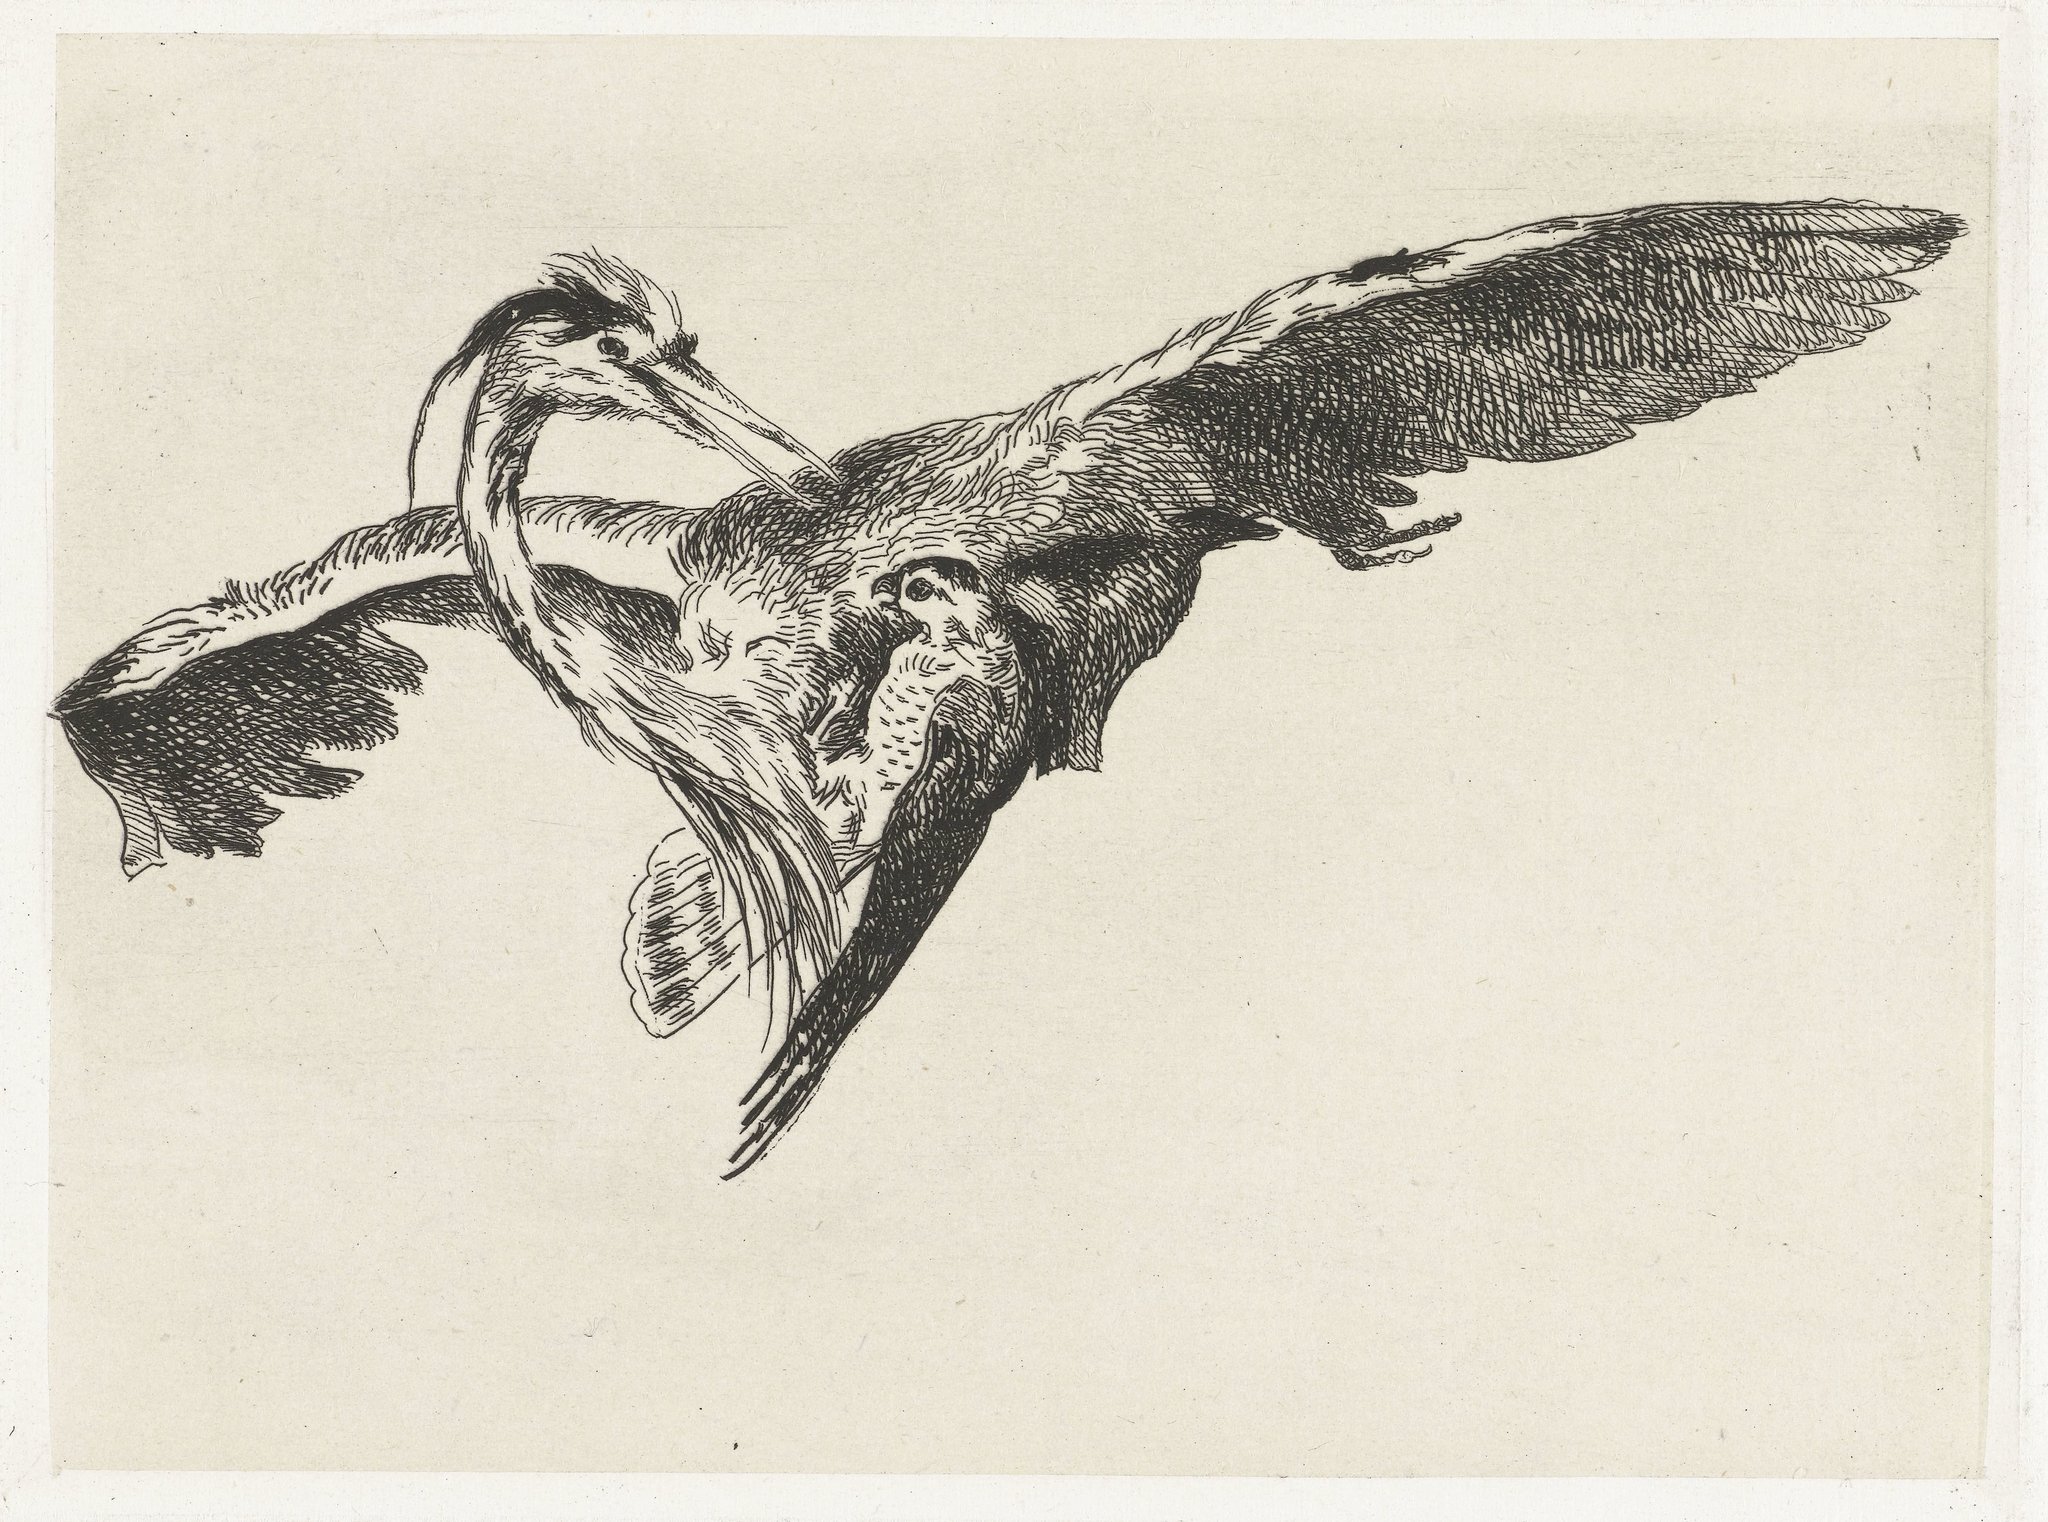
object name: print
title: Een valk overvalt een reiger in de vlucht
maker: guillaume anne van der brugghen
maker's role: draughtsman, print maker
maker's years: 1812-1891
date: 1826-1889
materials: paper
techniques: etching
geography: netherlands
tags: shore-birds and wading-birds: heron, sports, games ~ animals (+ hunting with falcon, hawk; falconry)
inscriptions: collector's mark: Lugt 2228